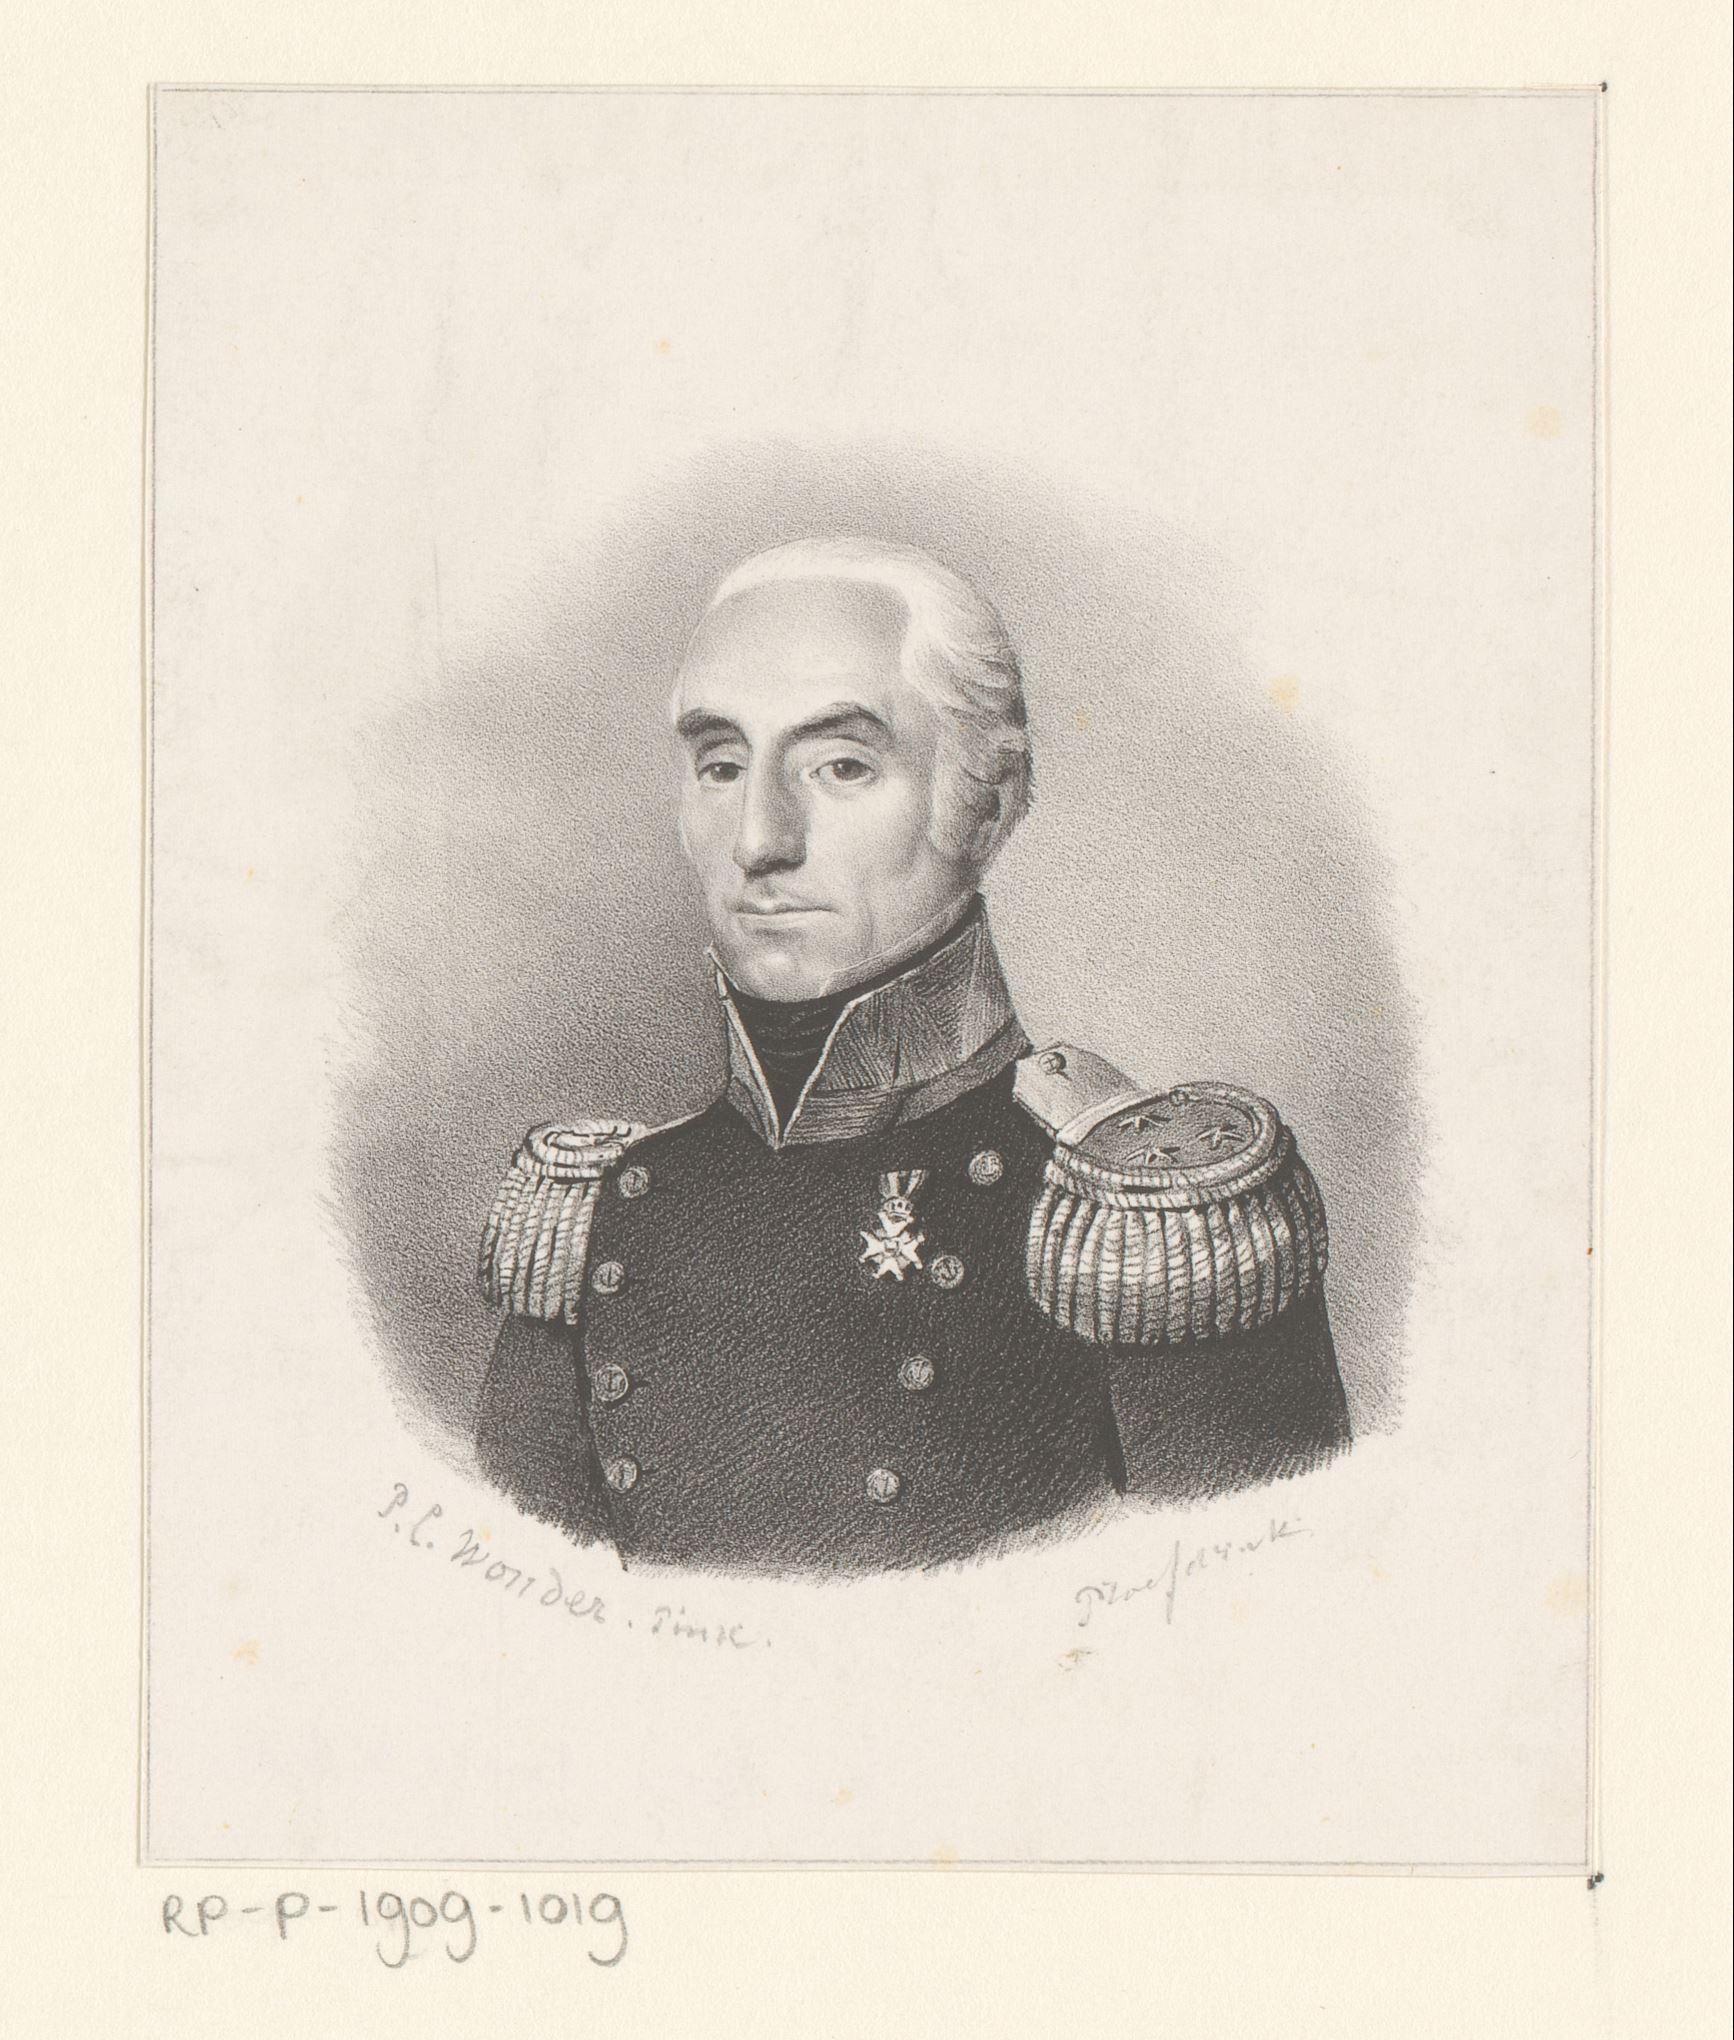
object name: print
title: Portret Jan van den Velden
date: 1822-1845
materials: paper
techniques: lithograph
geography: netherlands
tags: utrecht, mayor, knighthood order, historical persons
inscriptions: collector's mark: Lugt 2228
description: De geportretteerde draagt een militair uniform en een ridderorde op de borst.